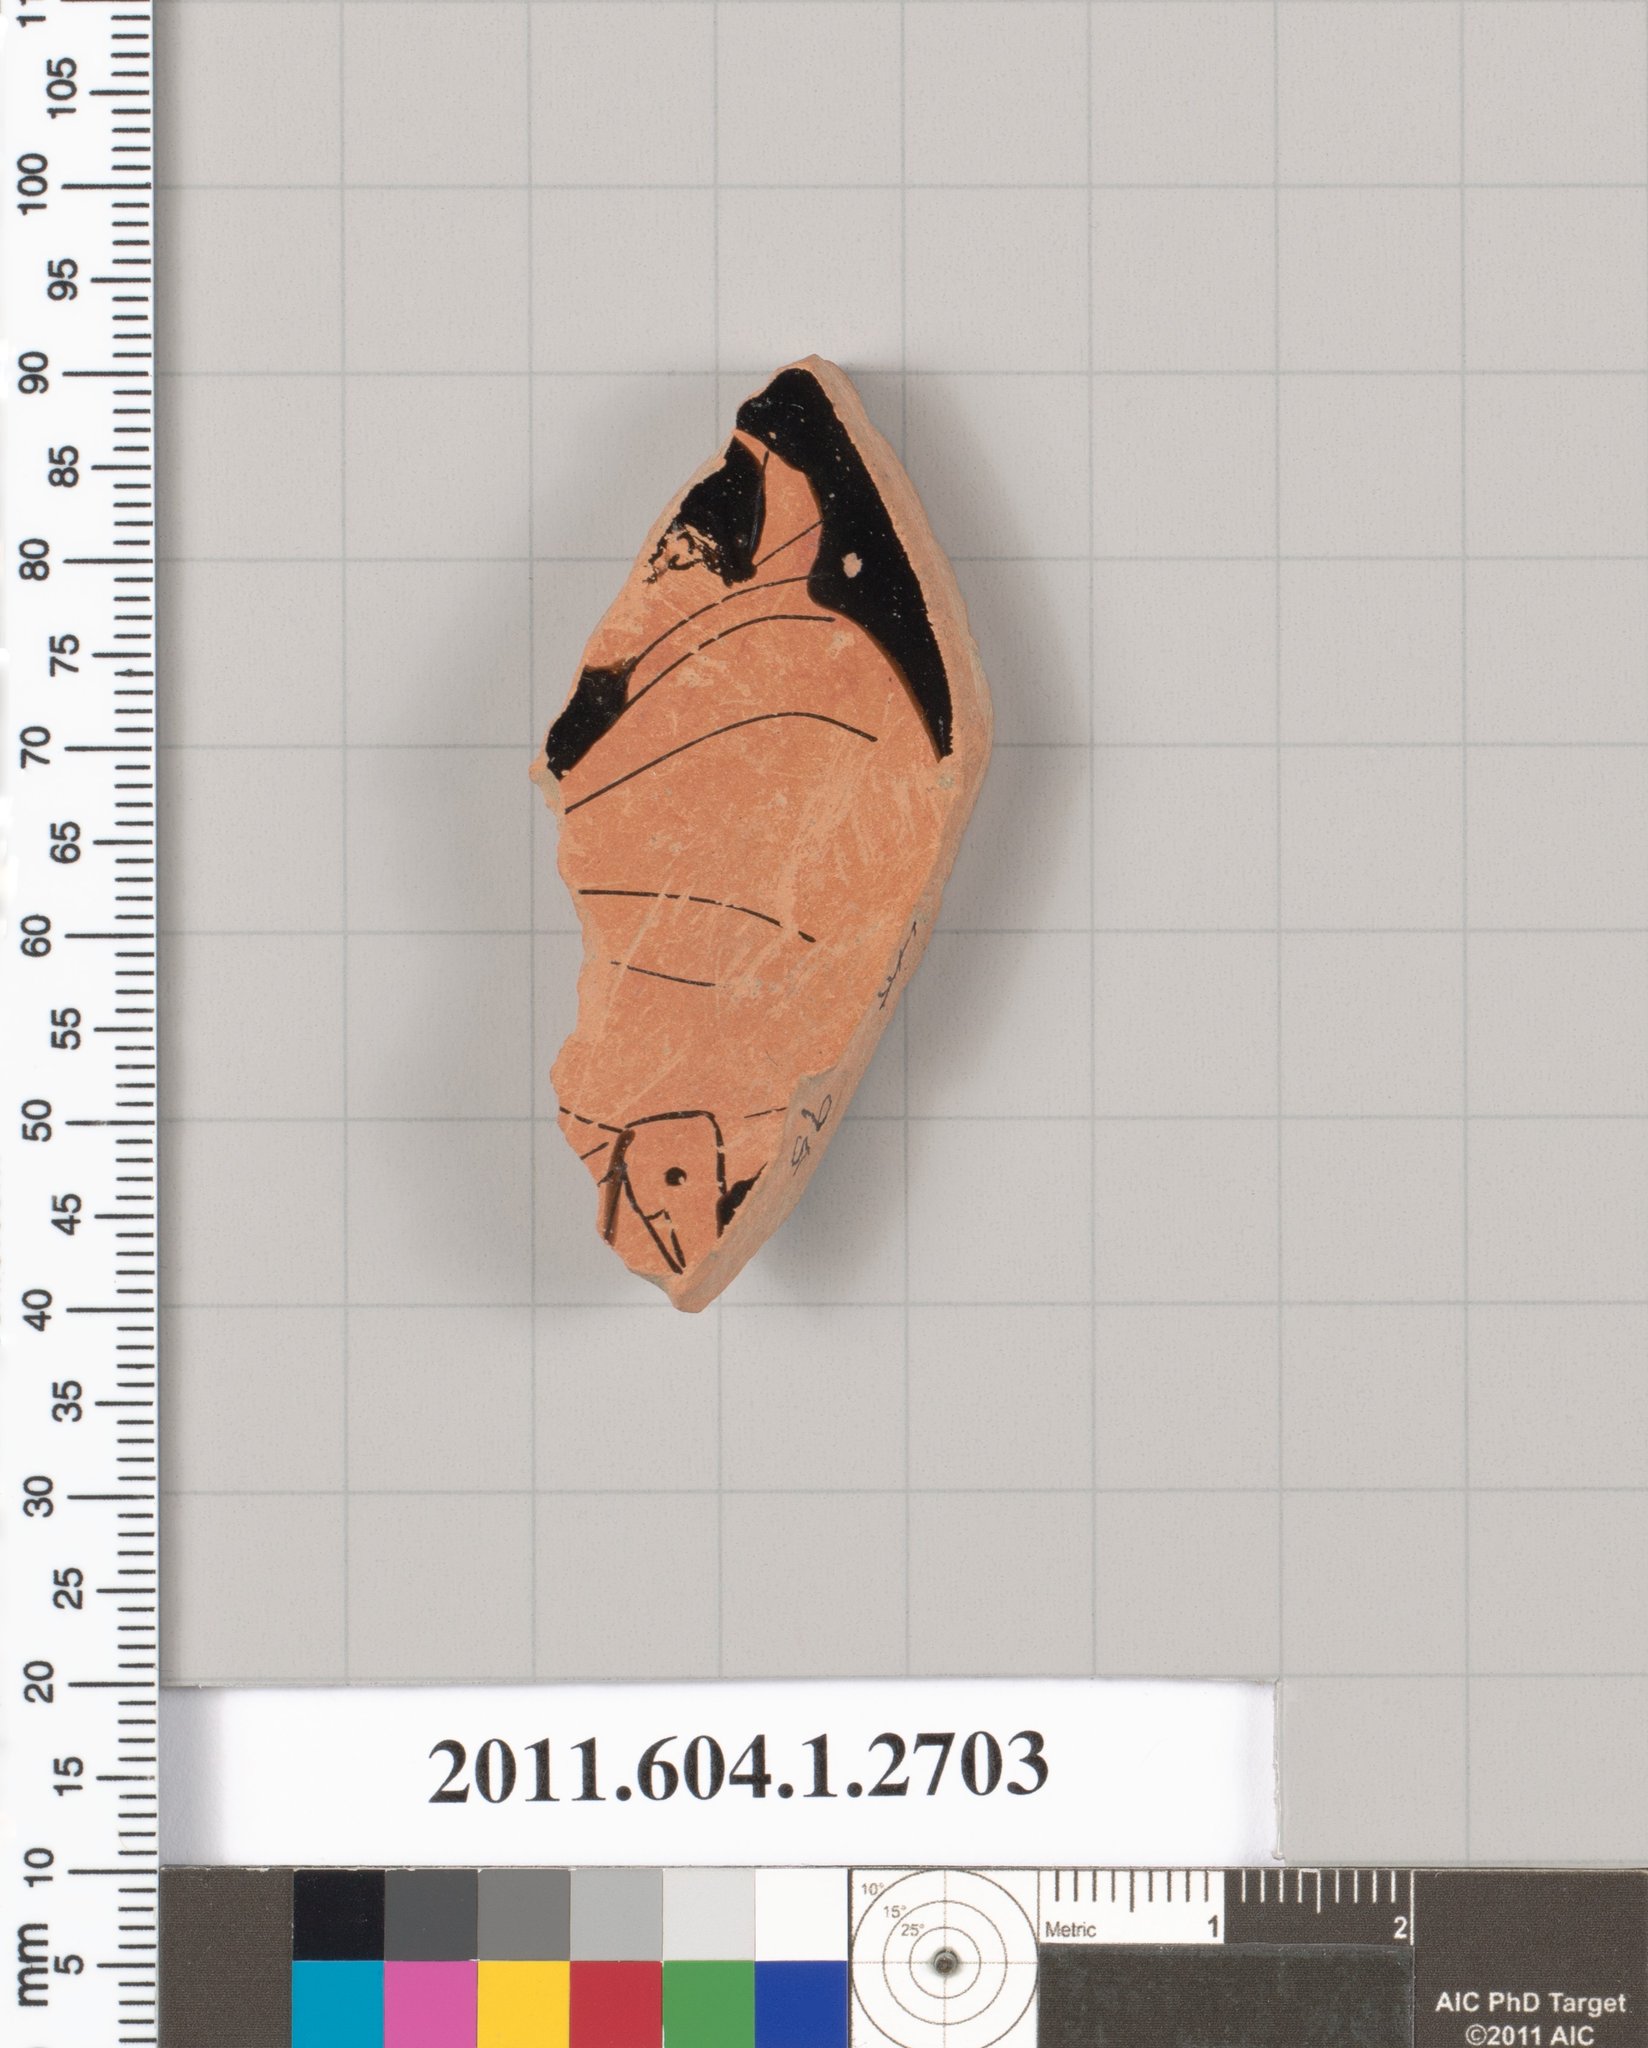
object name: kylix fragment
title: Terracotta fragment of a kylix (drinking cup)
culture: greek, attic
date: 475-451 BCE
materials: terracotta